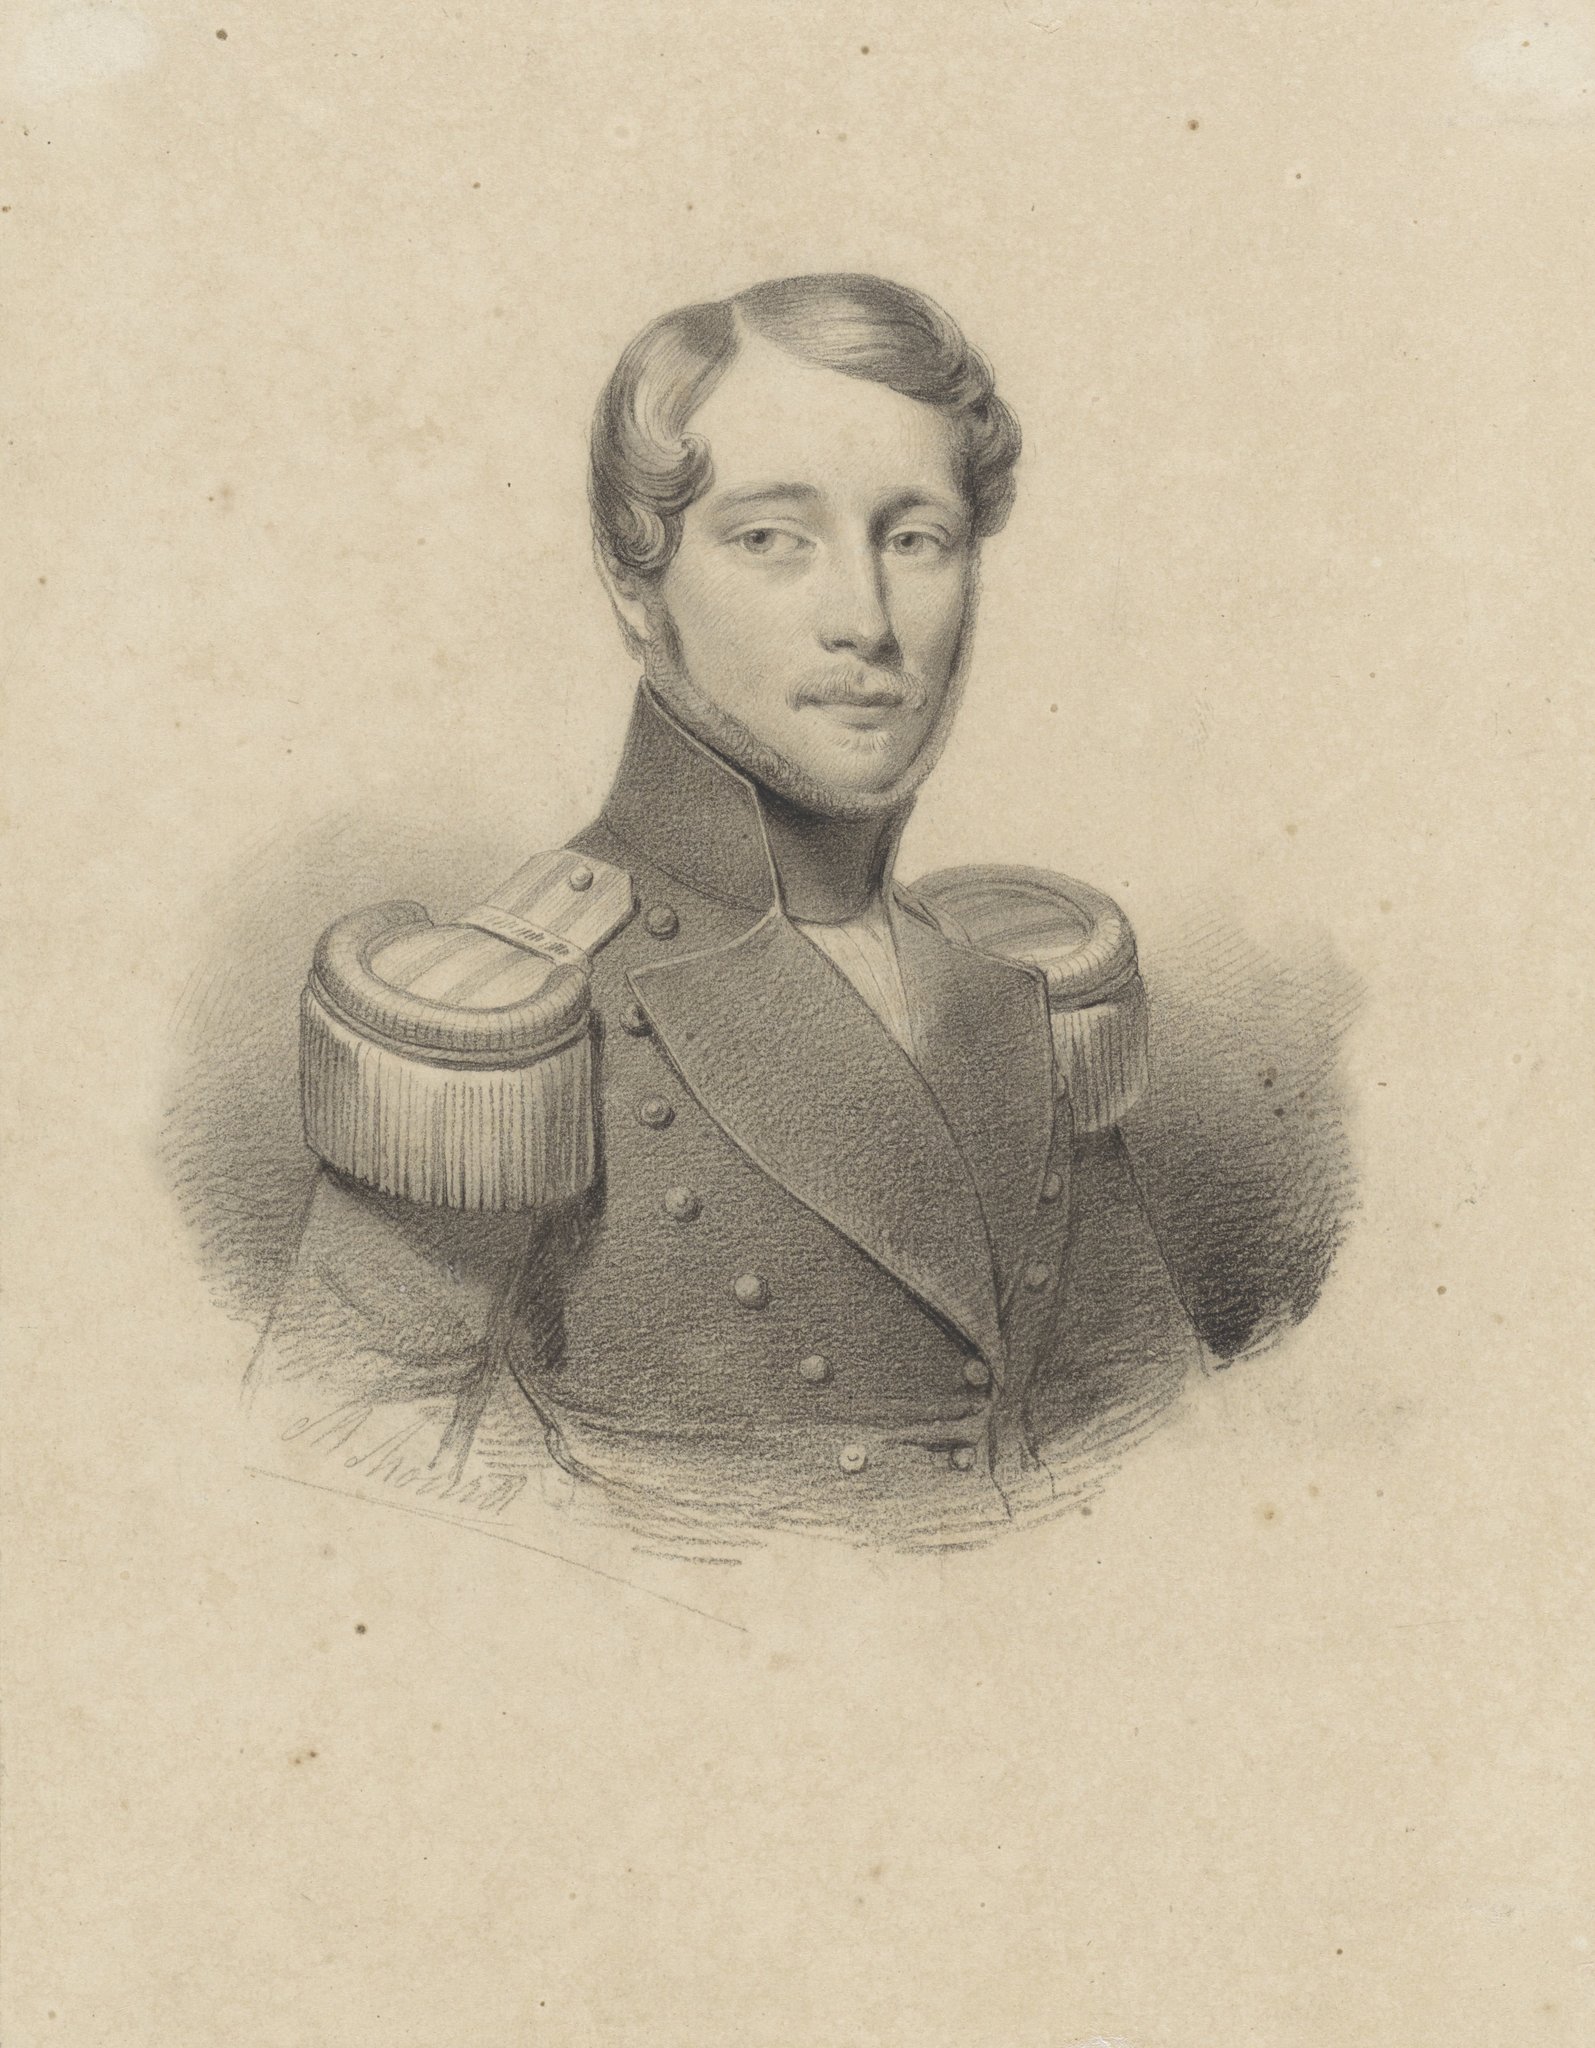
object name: drawing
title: Portret van een officier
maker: michel mourot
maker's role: draughtsman, print maker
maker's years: 1803-1847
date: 1838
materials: chalk, paper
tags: anonymous historical person portrayed alone